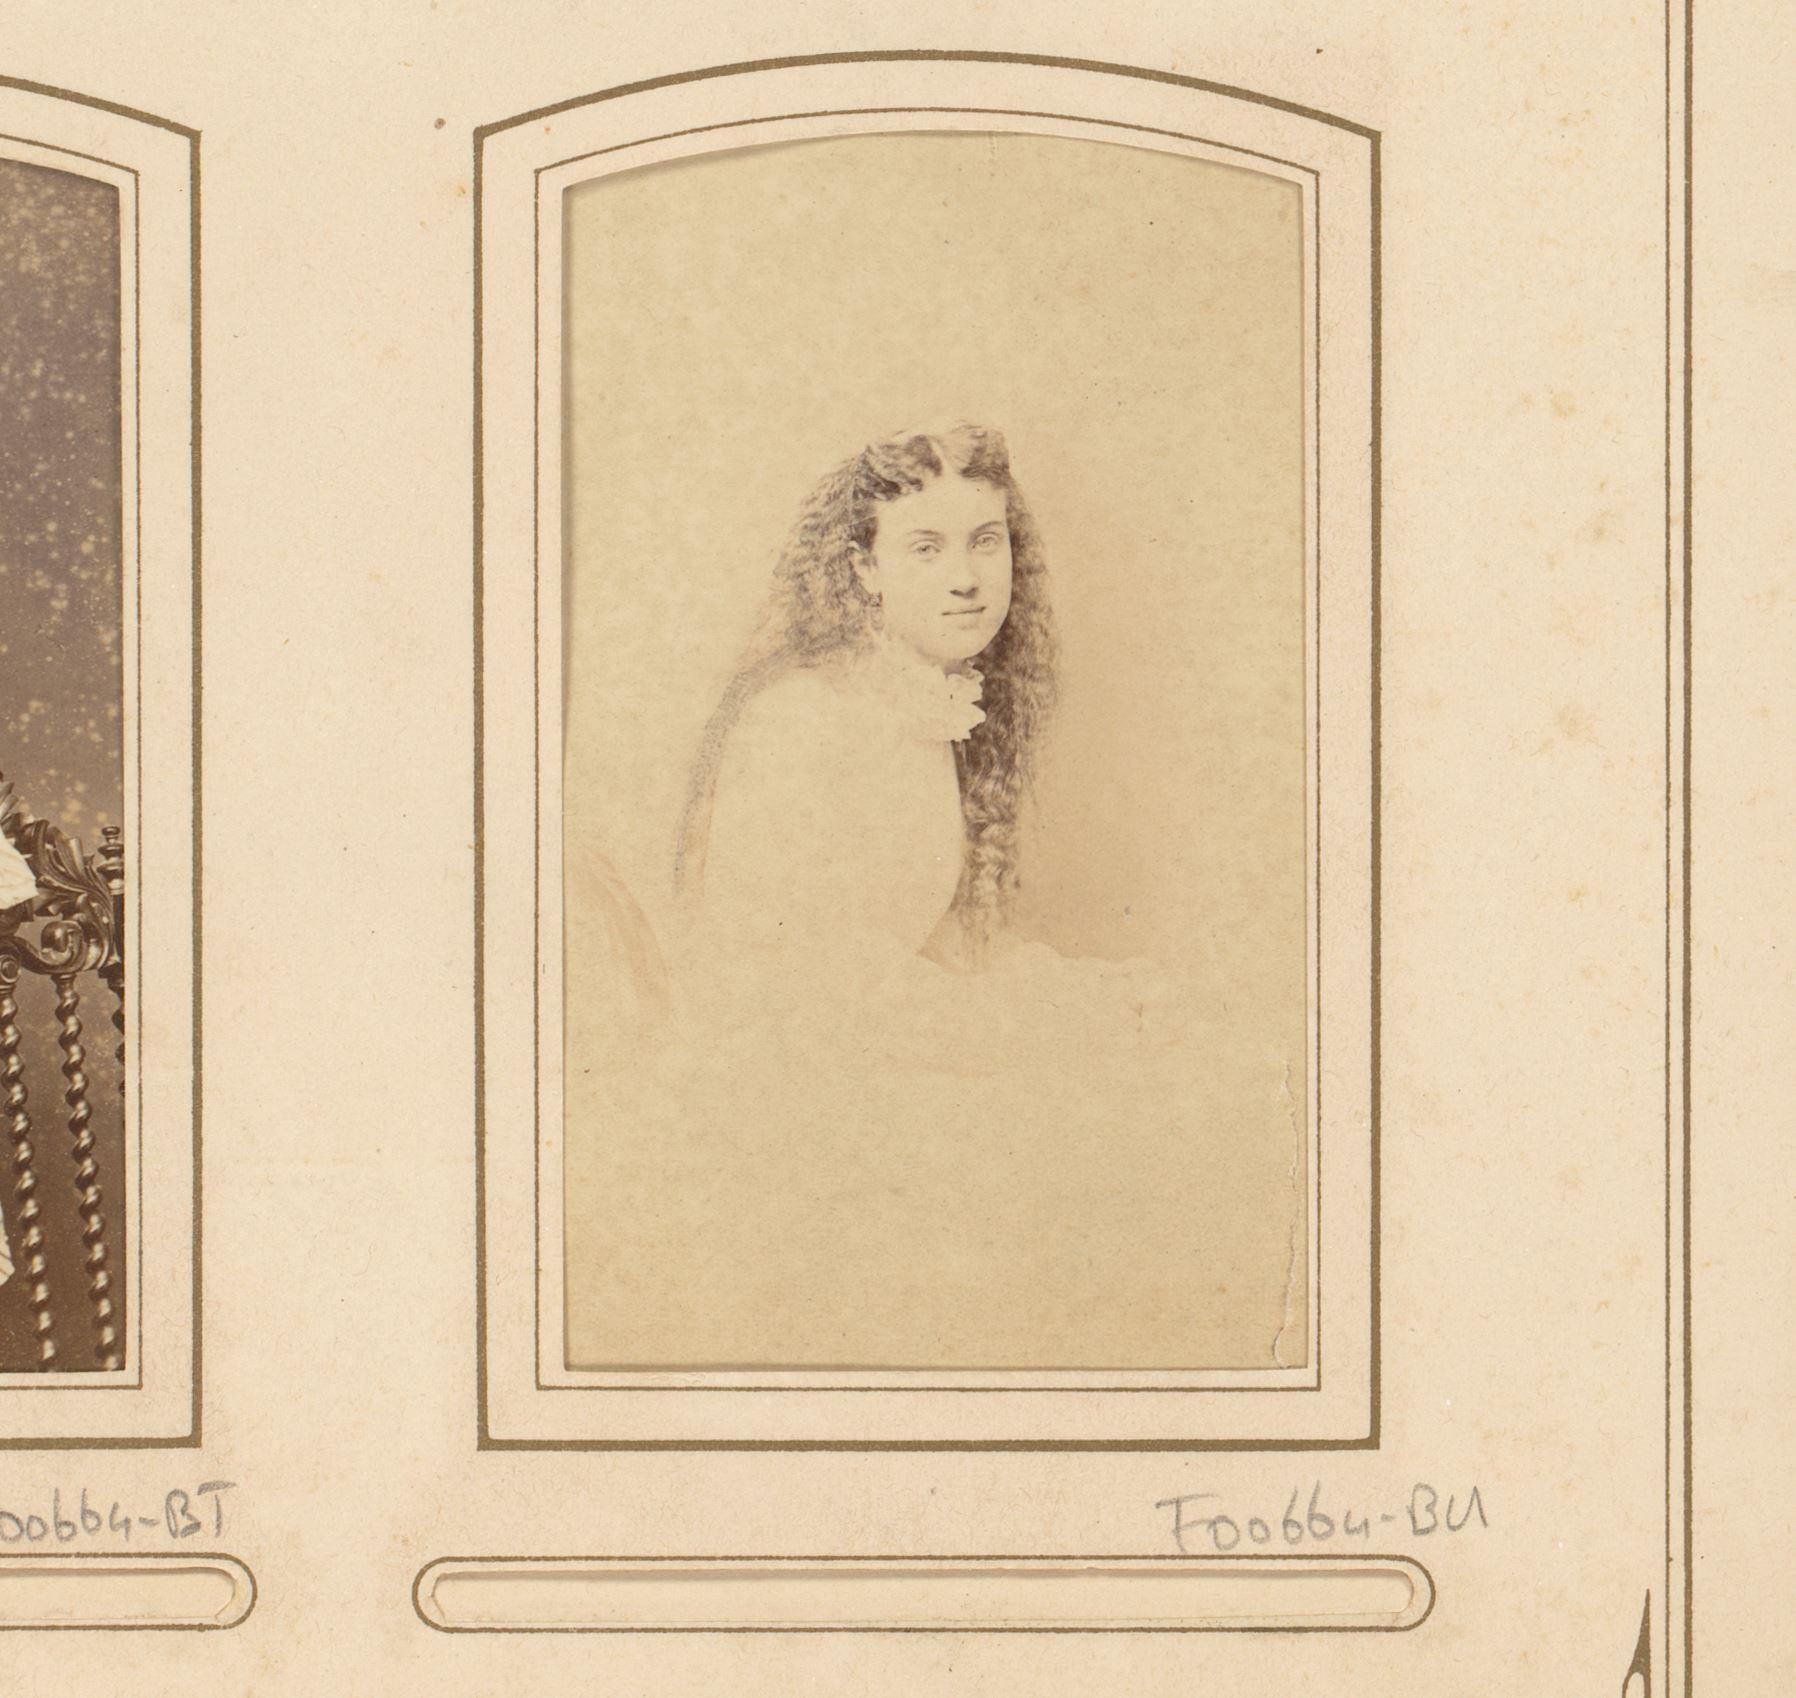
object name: photograph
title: Portret van Amy Stephen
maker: john botterill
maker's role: fotograaf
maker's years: 1817-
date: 1871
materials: cardboard, photographic support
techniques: albumen print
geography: melbourne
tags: historical persons - bb - woman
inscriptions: inscription: ‘Botterill/ Portrait Painter and Photographer/ 19, Collins, Street, East/ Melbourne’, annotation: ‘Amy Stephen/ with kind regards/ 1871/ [...]/ Melbourne’